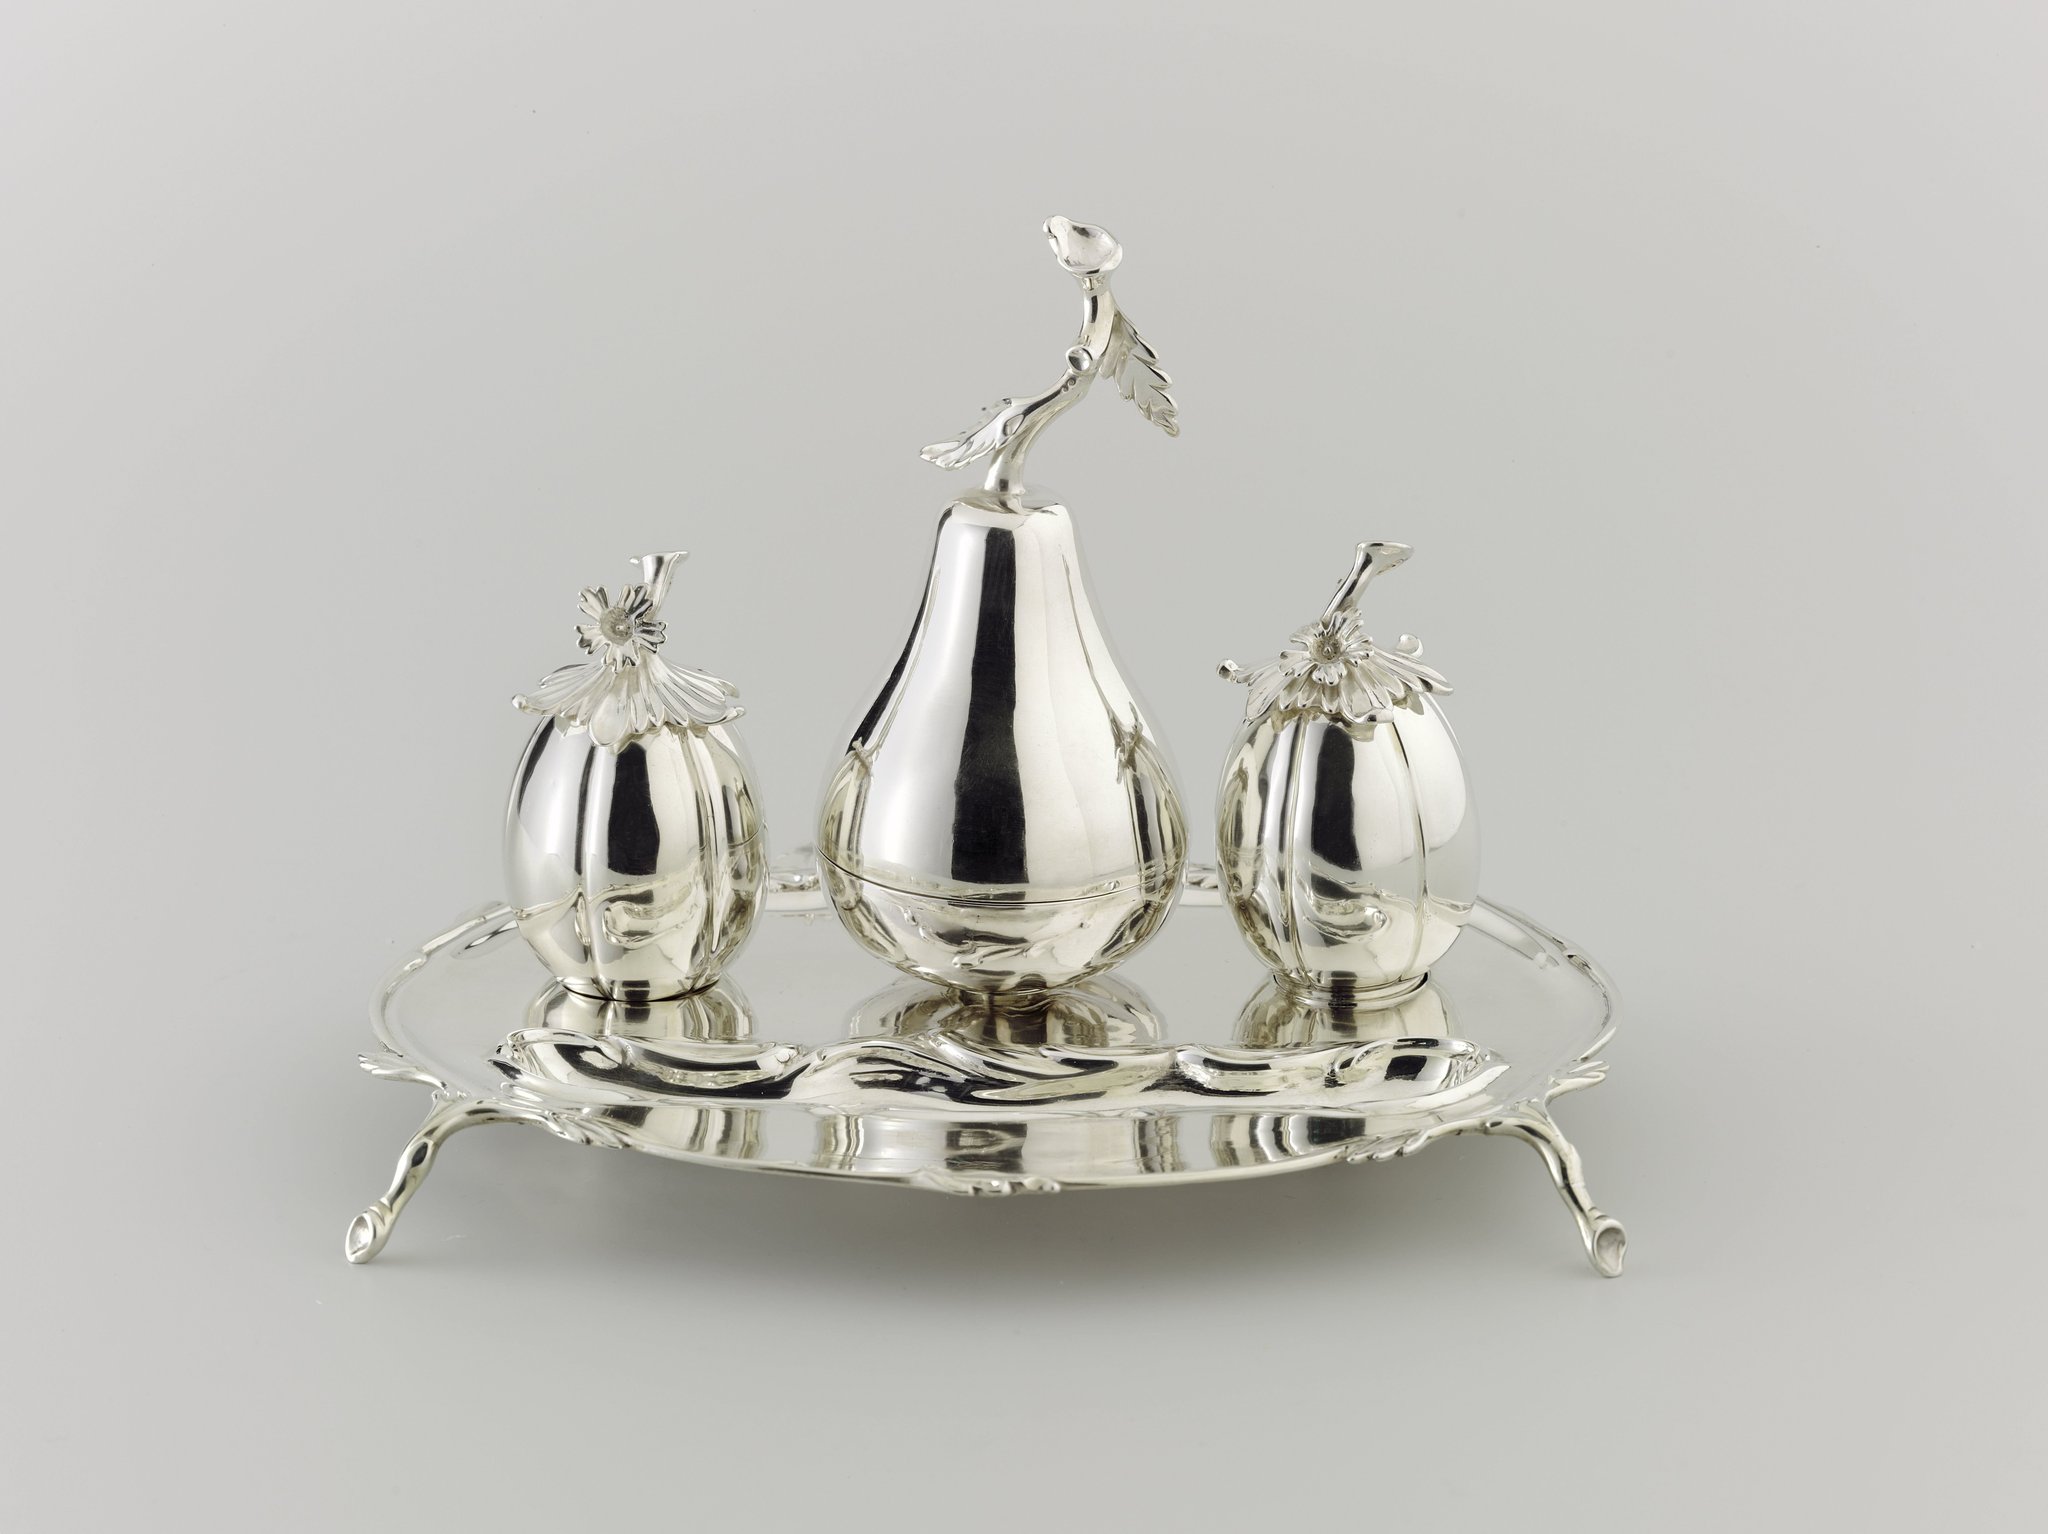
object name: inkstand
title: Inktpot behorend bij inktstel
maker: laurens potmans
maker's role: goud- en zilversmid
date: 1773-1782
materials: silver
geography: middelburg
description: Inktstel van zilver. Het blad is aan de achterzijde recht en aan de voorzijde gebogen. De inktpot en zandstrooier zijn meloenvormig. Tussen de twee meloenen is de peervormige tafelbel aangebracht.